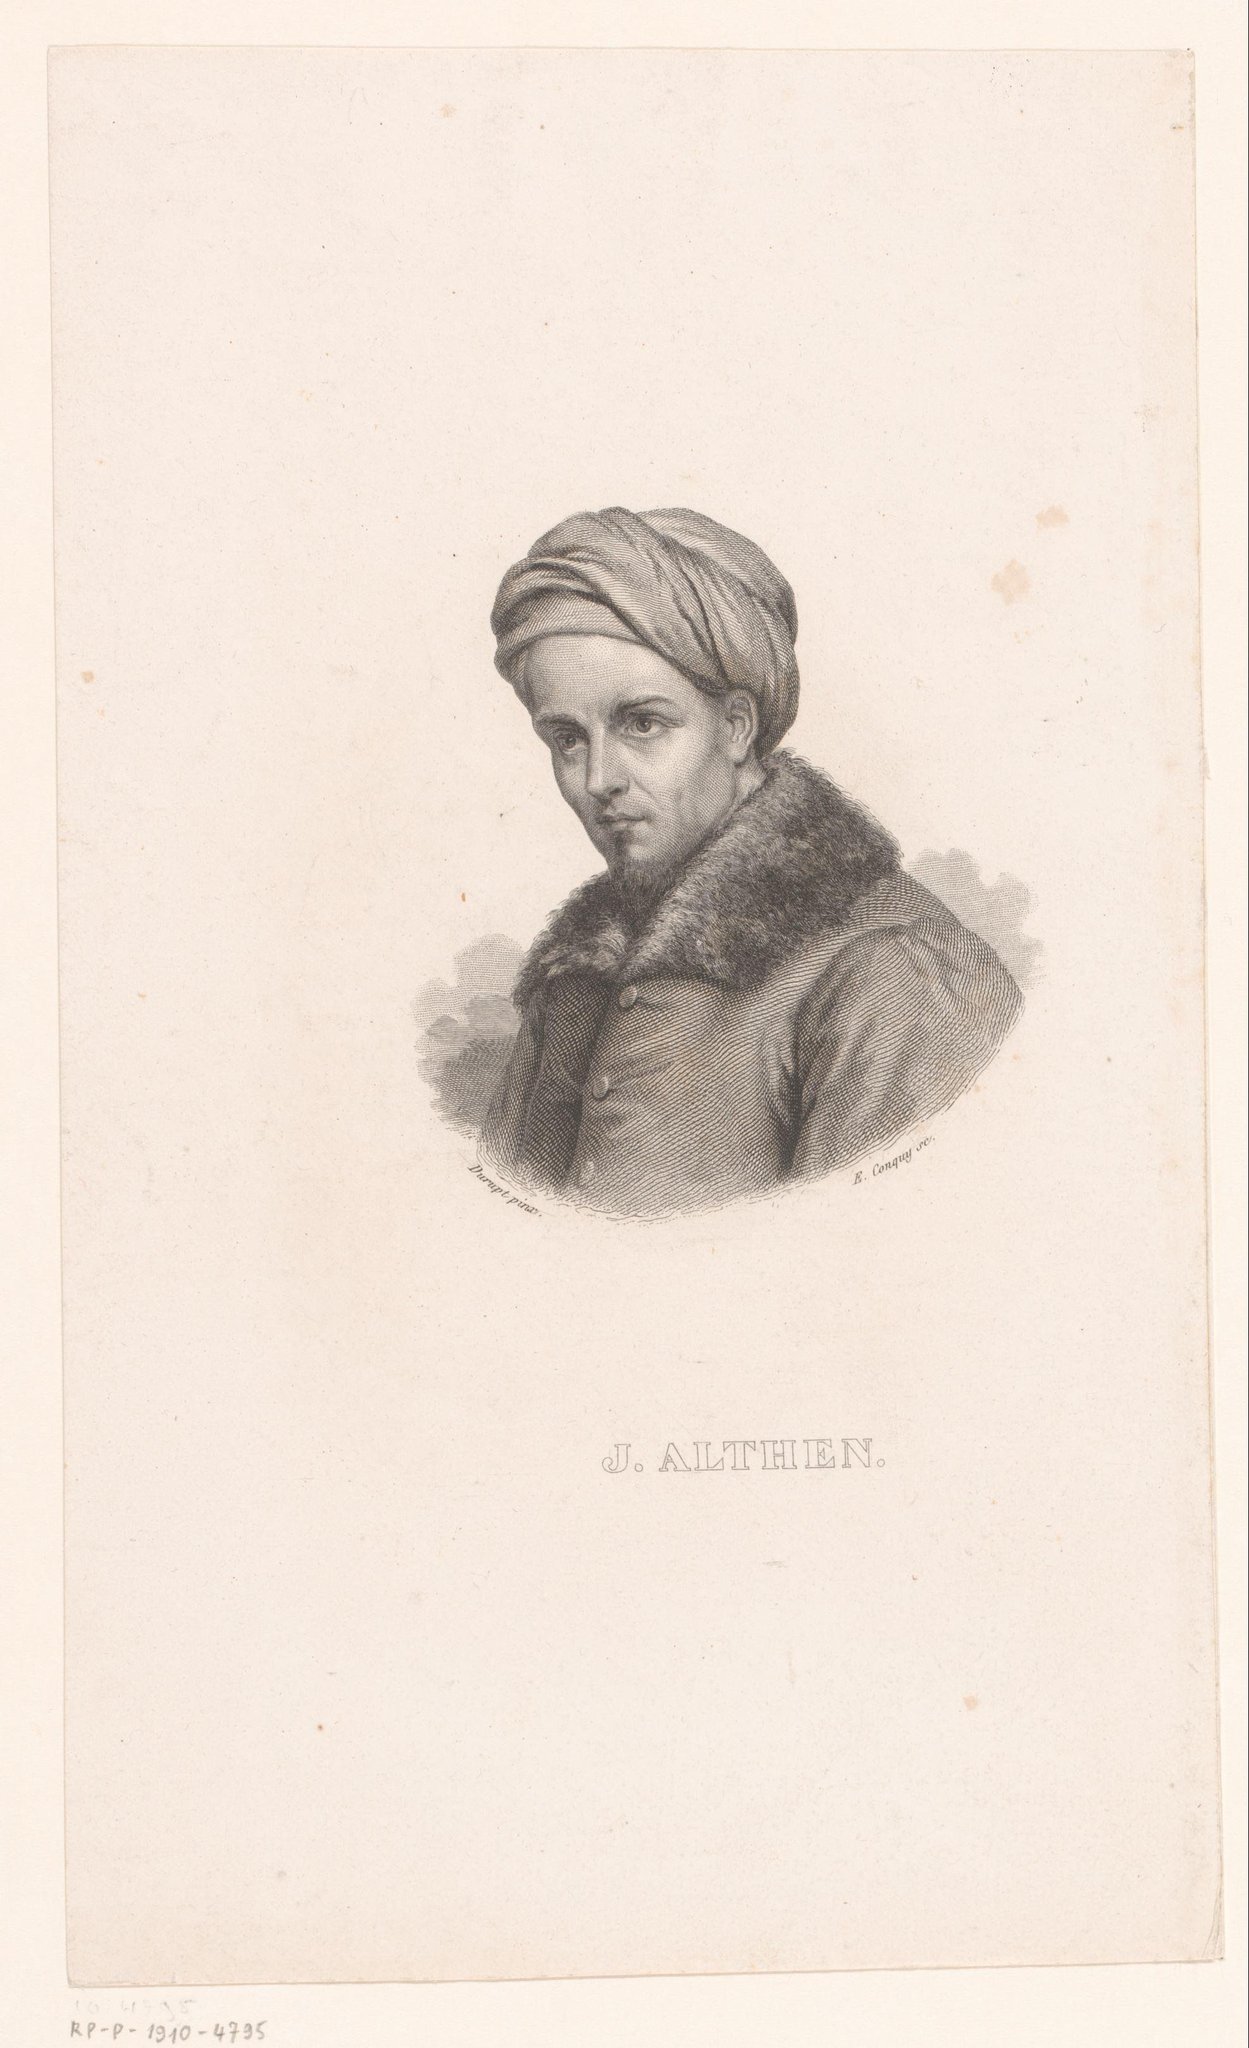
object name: print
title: J. Althen.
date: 1819-1843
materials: paper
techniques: engraving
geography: france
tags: historical persons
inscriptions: collector's mark: Lugt 2228